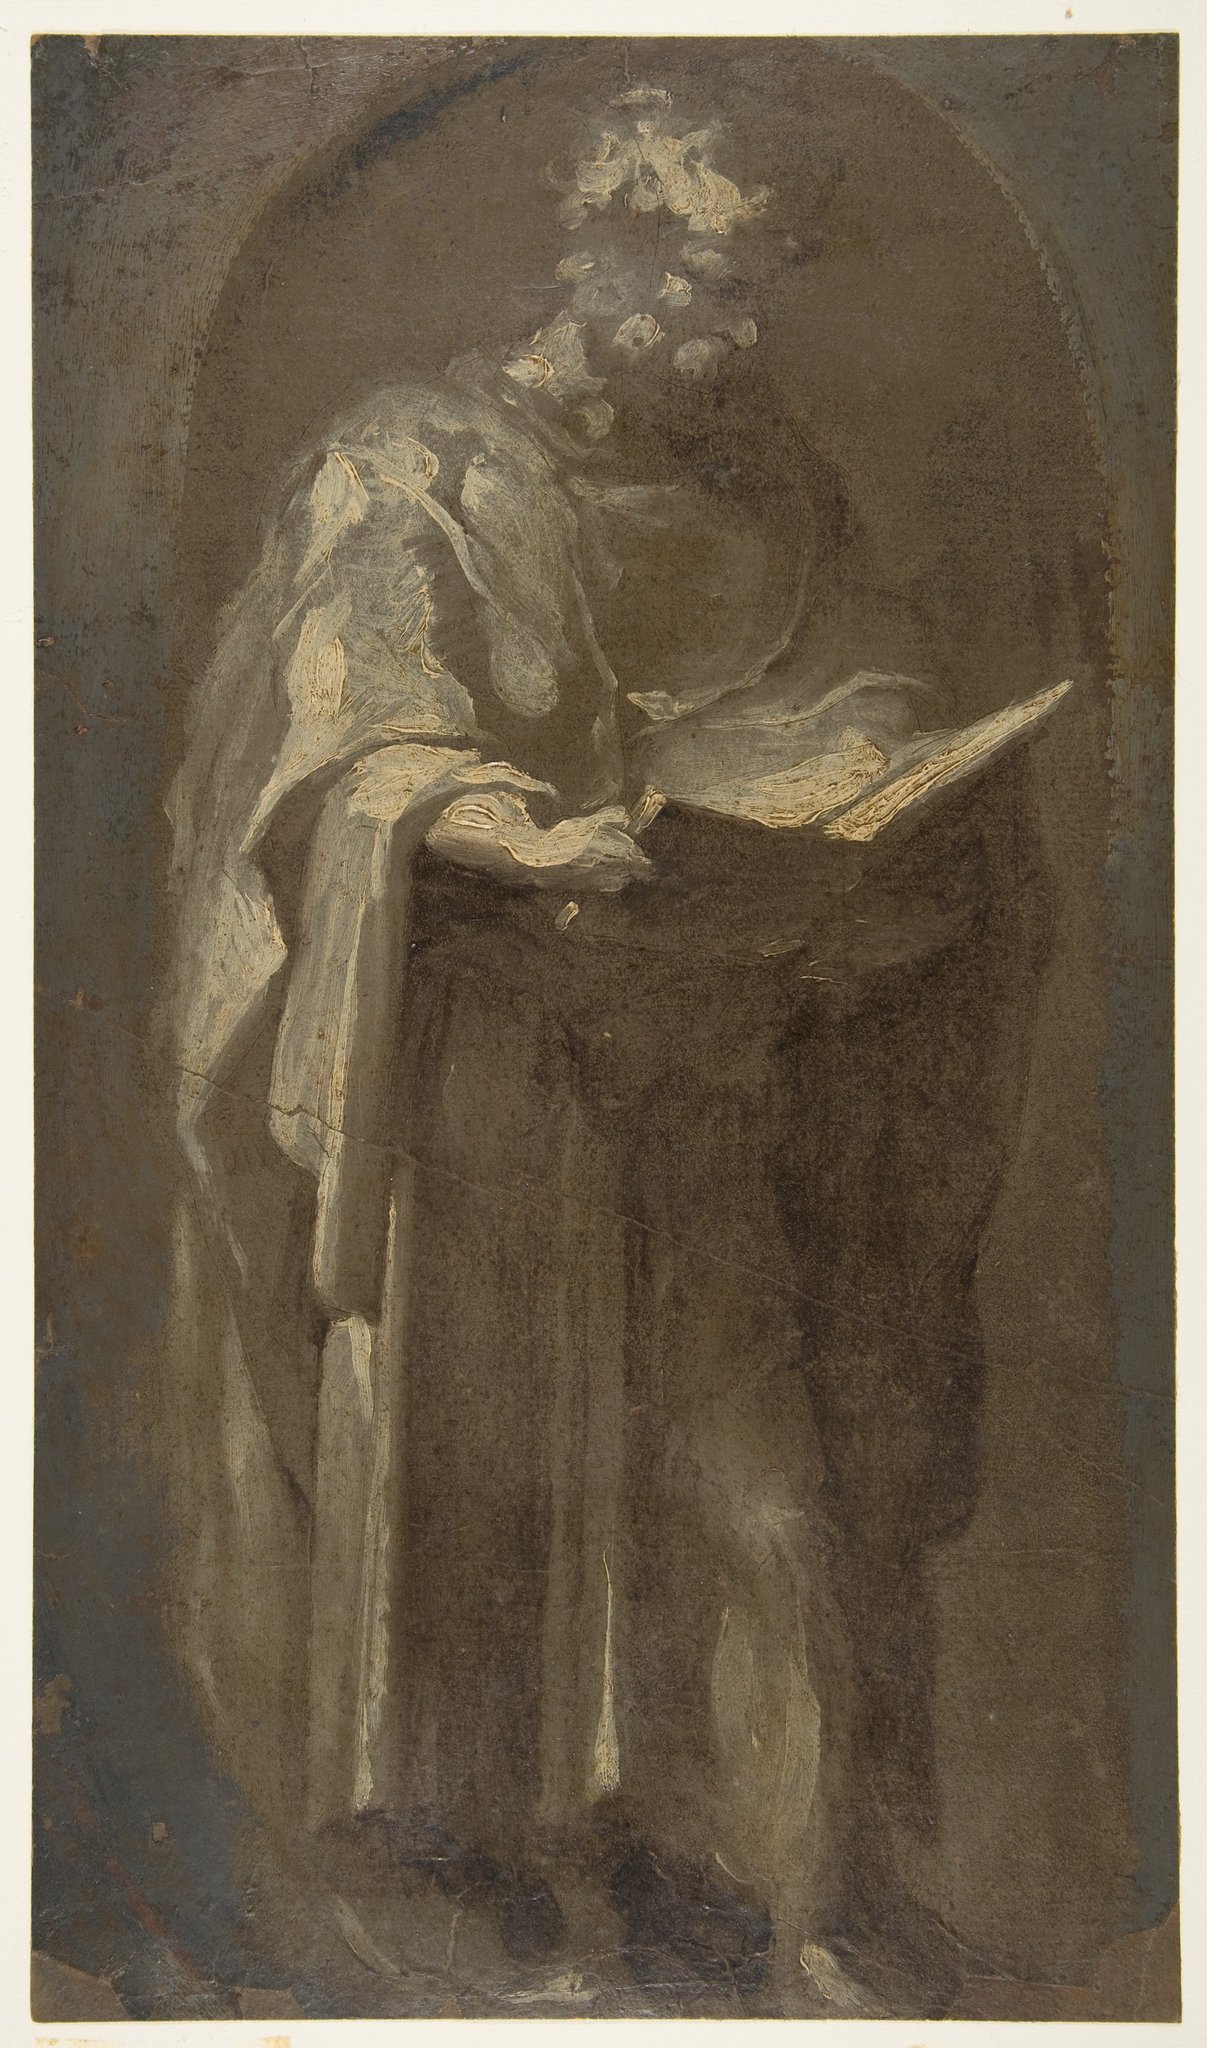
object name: drawing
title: Saint Mark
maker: domenico beccafumi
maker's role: artist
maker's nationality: italian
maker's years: 1484-1551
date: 1538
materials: paper, paint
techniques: brush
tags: reading,saint mark